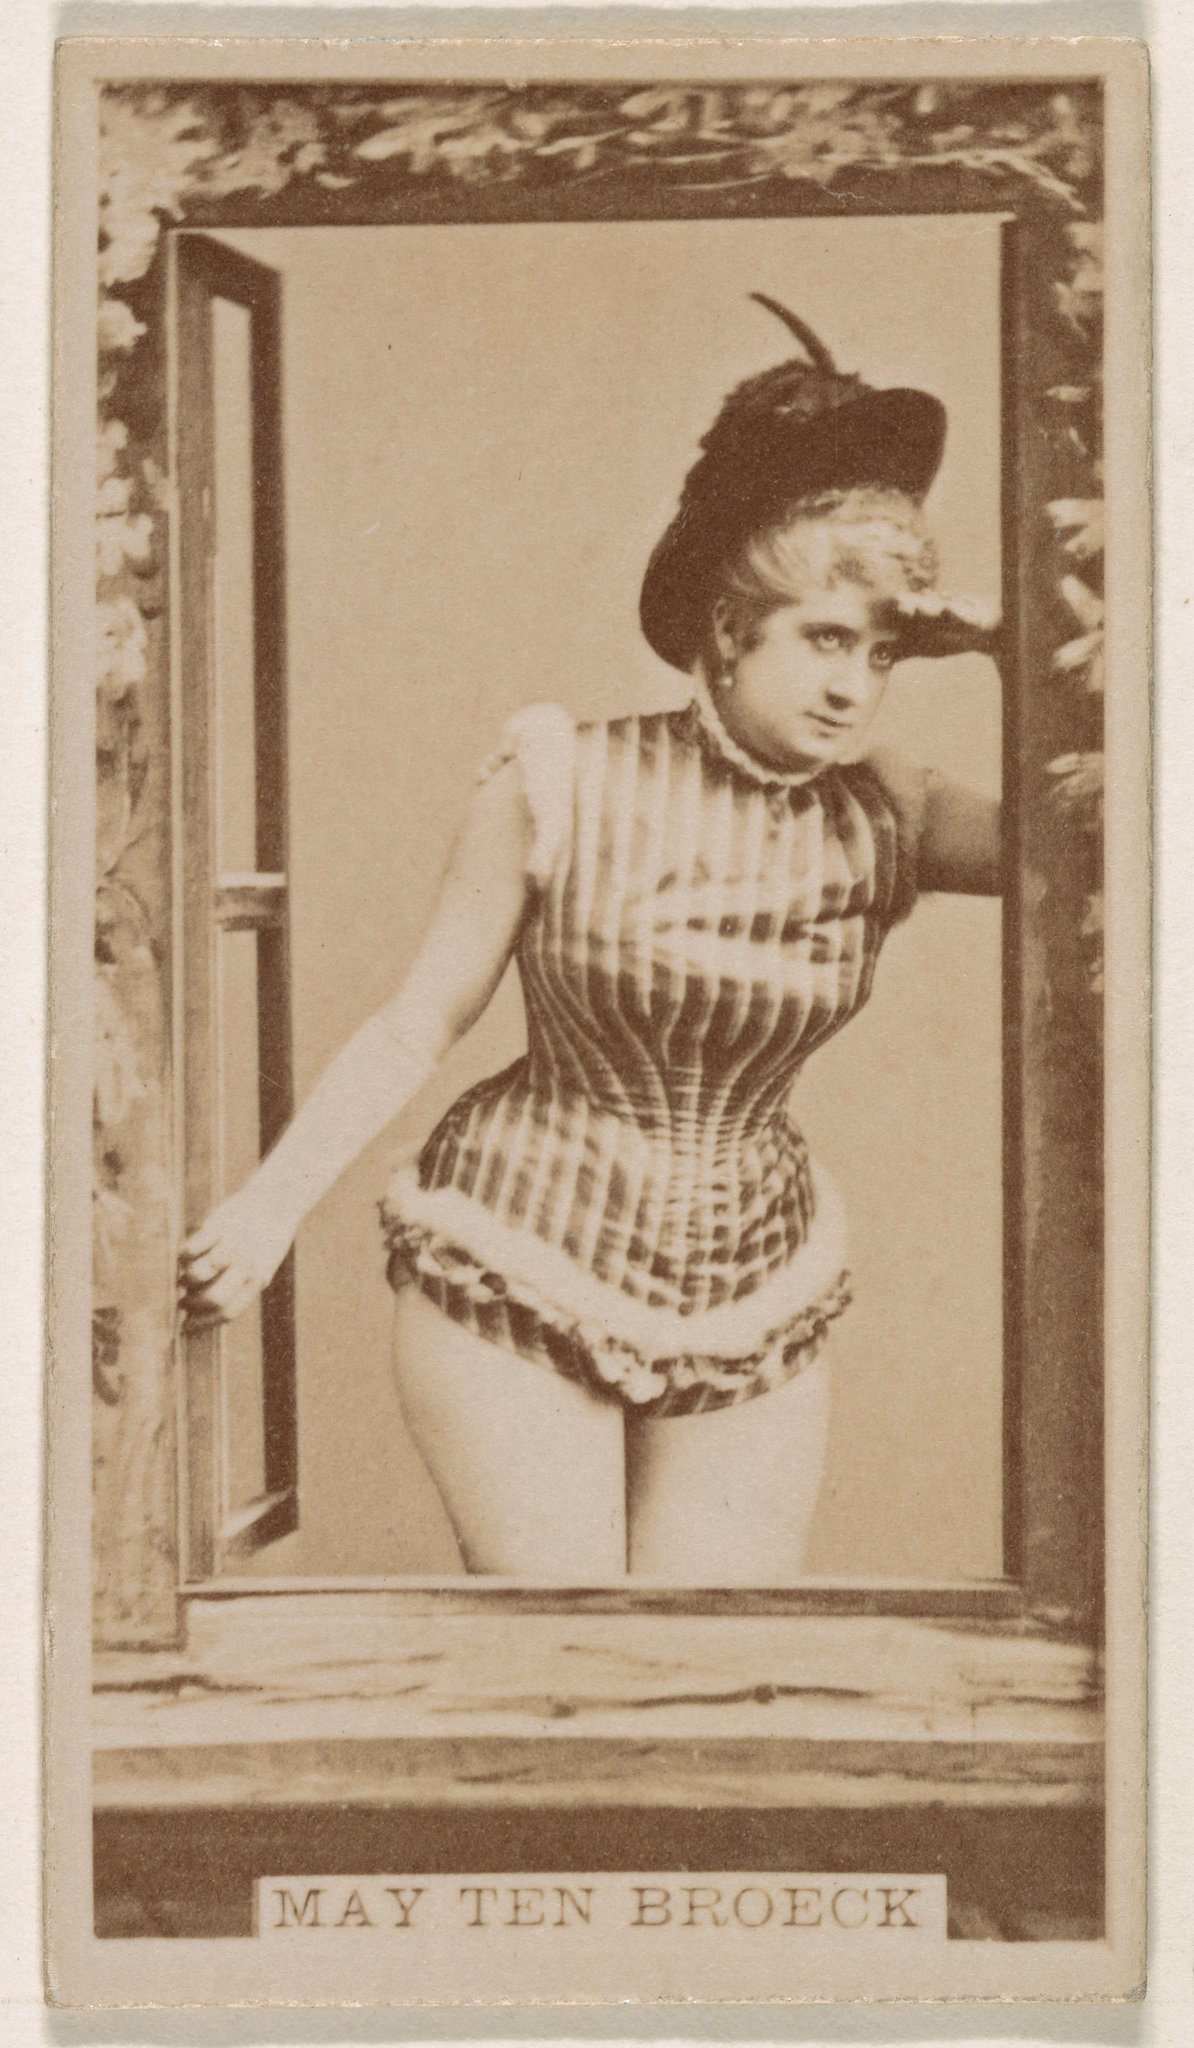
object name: photograph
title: May Ten Broeck, from the Actresses series (N245) issued by Kinney Brothers to promote Sweet Caporal Cigarettes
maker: kinney brothers tobacco company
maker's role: publisher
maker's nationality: american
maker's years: 1869-2011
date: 1890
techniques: albumen silver print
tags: portraits,women,actresses